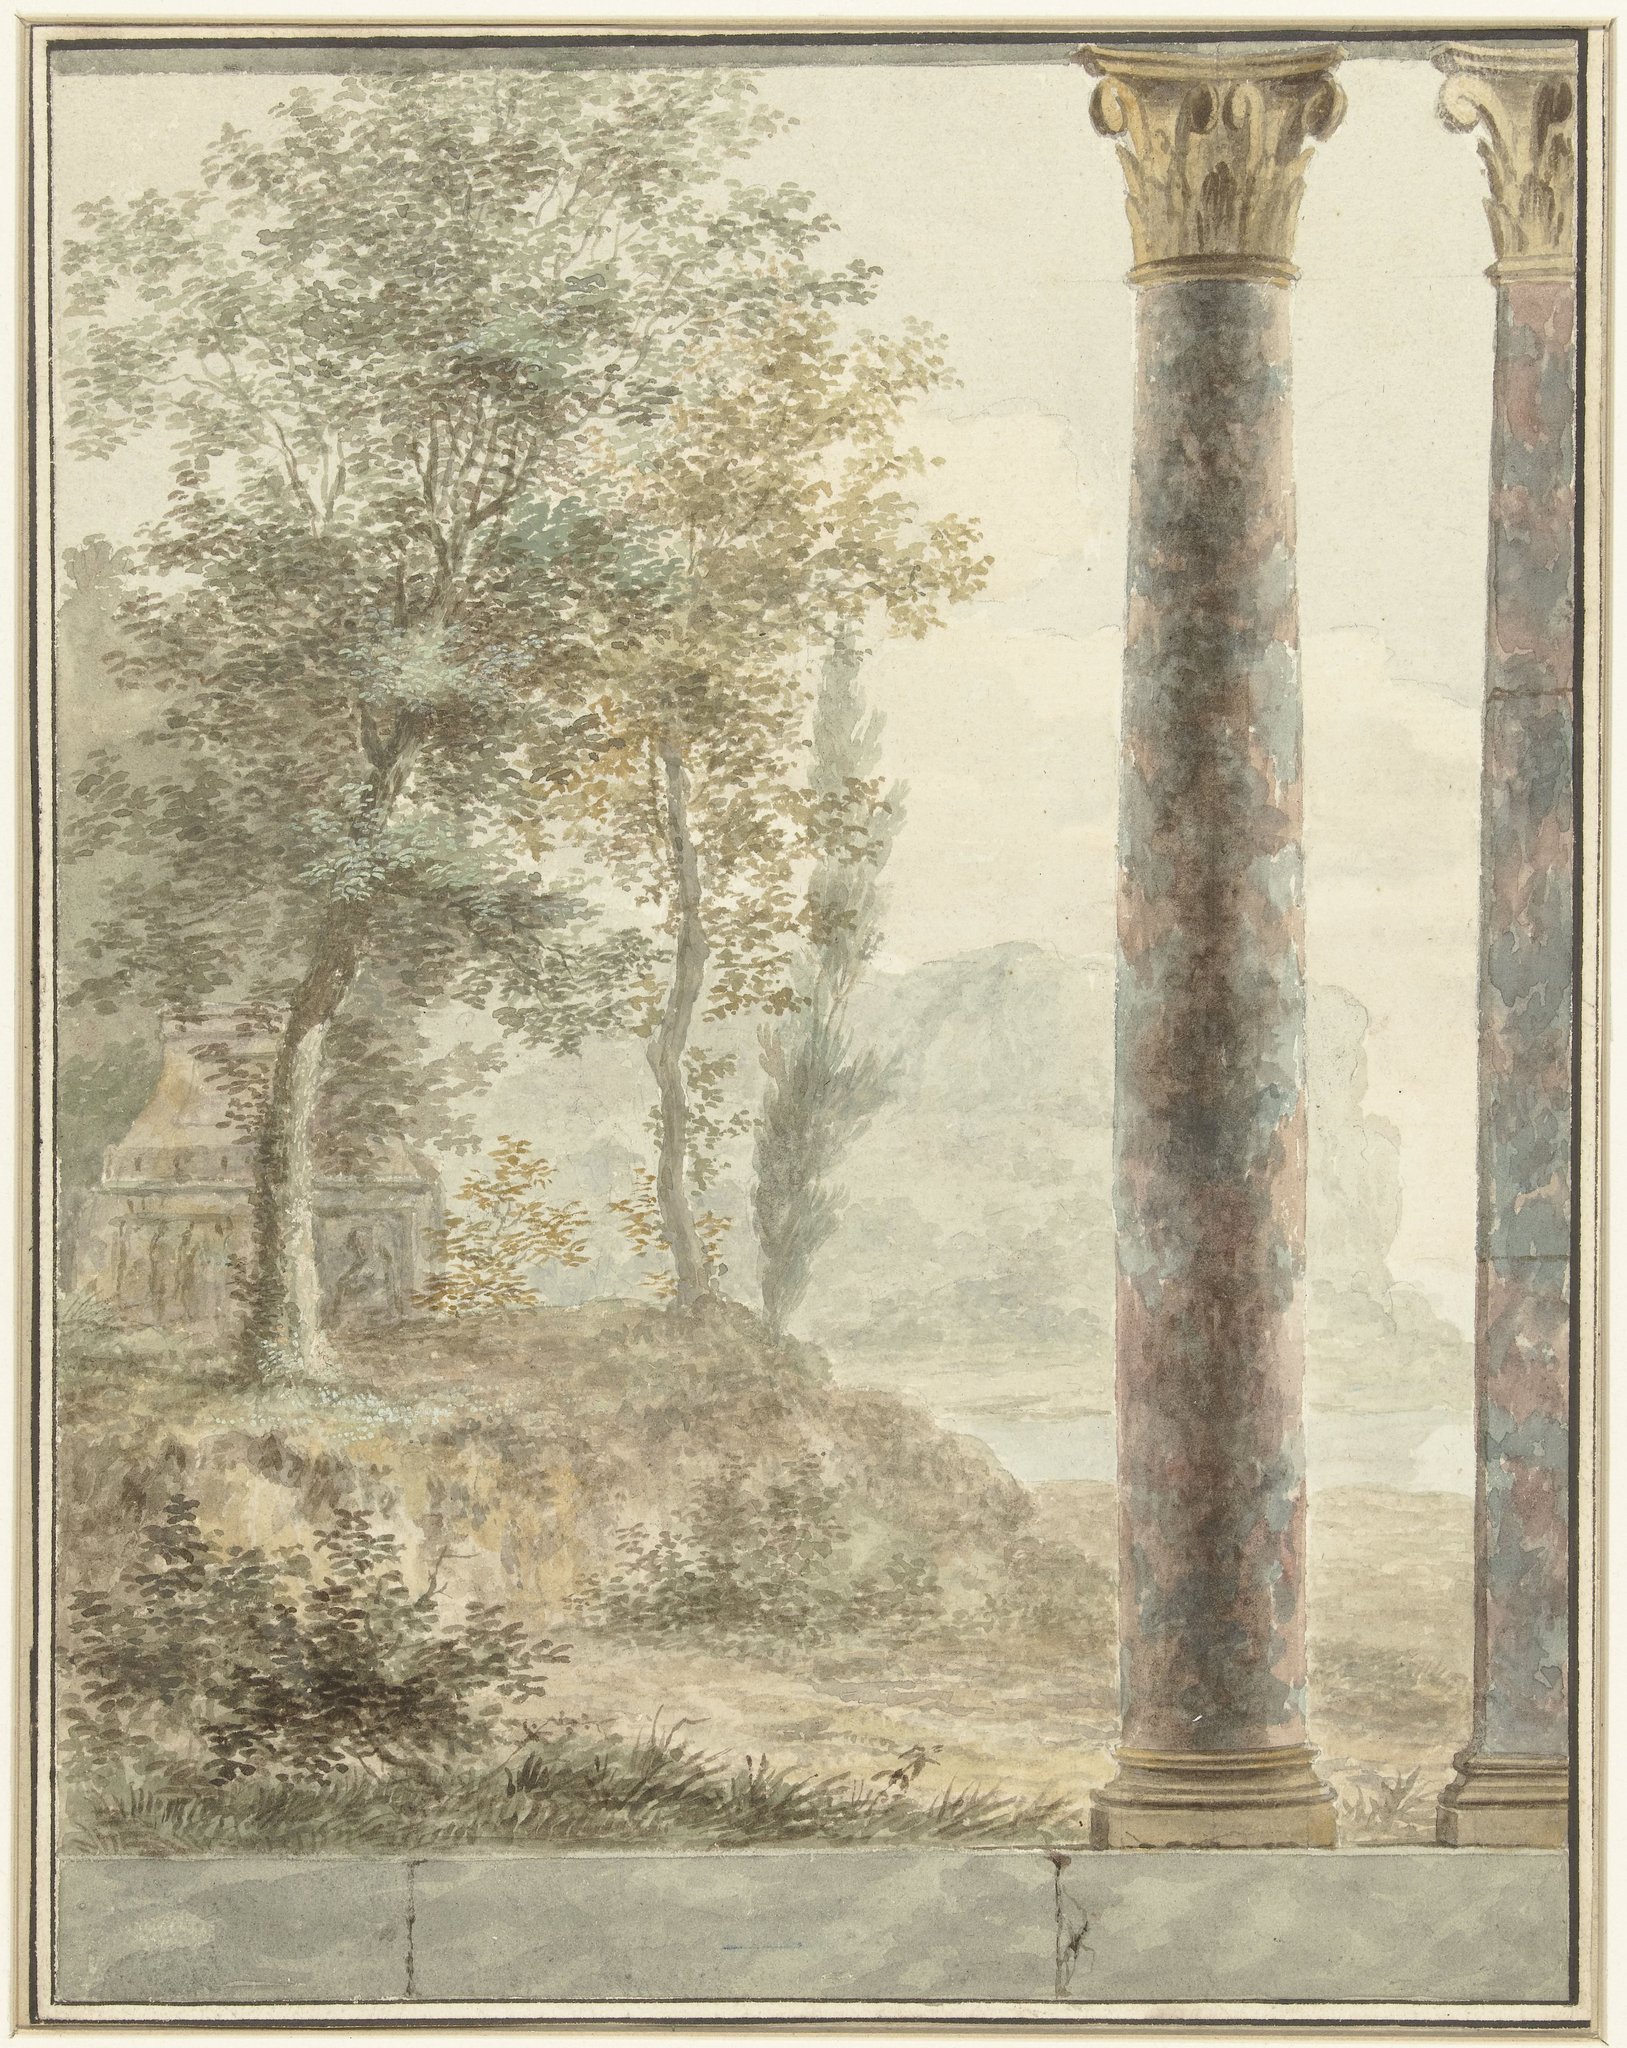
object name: design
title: Ontwerp voor kamerbeschildering met landschap met fragment van antiek bouwwerk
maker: Anonymous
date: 1700-1800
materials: paper, watercolor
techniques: brush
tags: landscape with ruins, landscape with monument, corinthian order ~ architecture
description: Ontwerp voor kamerbeschildering: landschap met fragment van antiek bouwwerk, op de voorgrond een Corinthische zuil en pilaster.